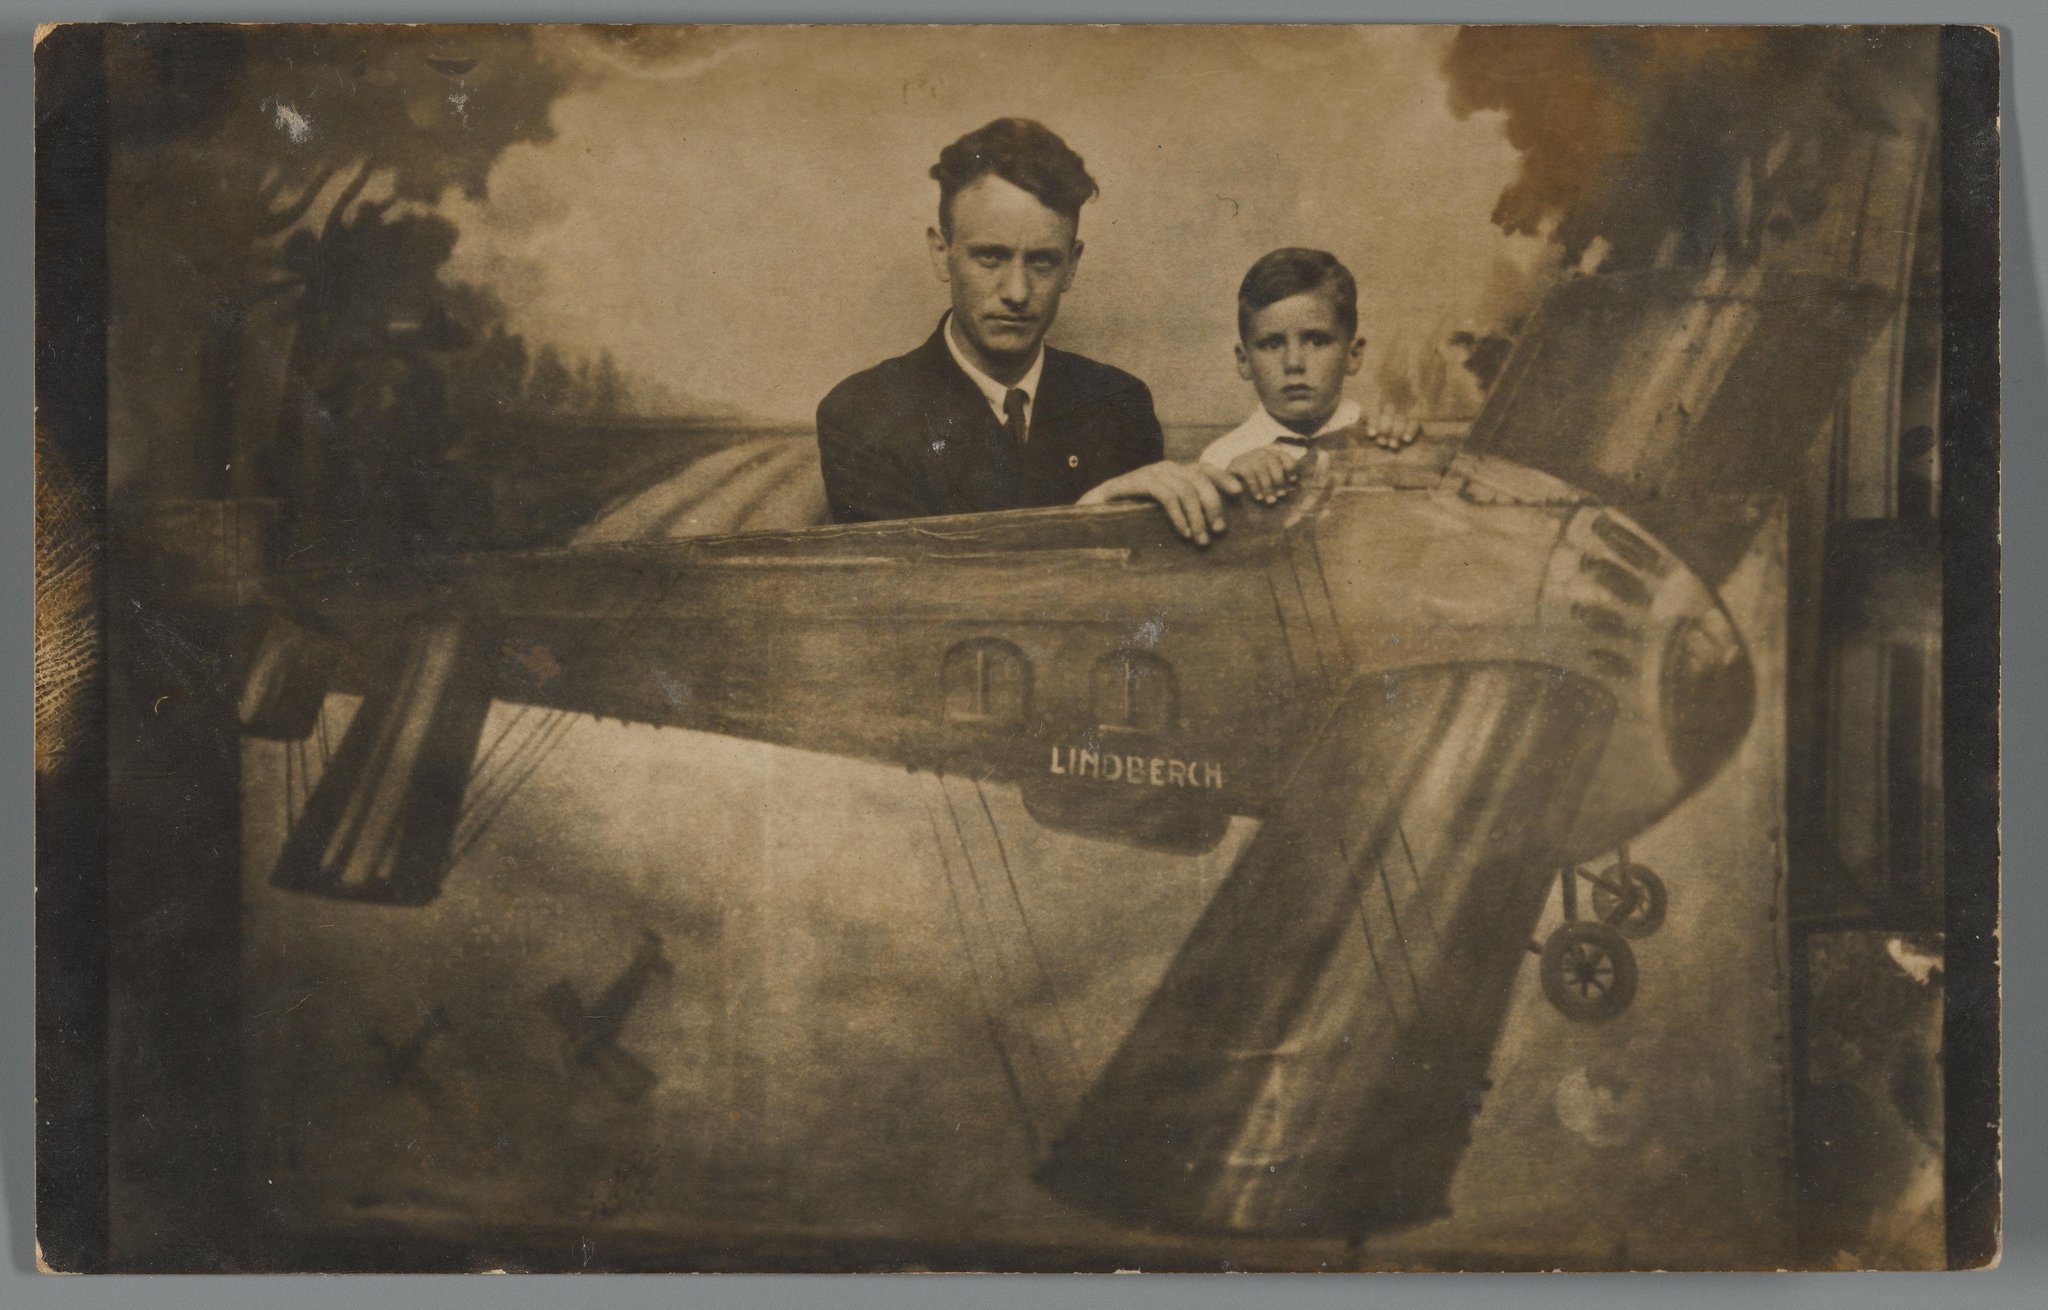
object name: photograph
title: Portret van A.H. Scheerder en zijn zoon Hendrikus Cornelis Scheerder in een imitatie-vliegtuig van Charles Lindbergh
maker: Anonymous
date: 1935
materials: paper, photographic support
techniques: gelatin silver print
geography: amersfoort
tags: a.h. scheerder, hendrikus cornelis scheerder